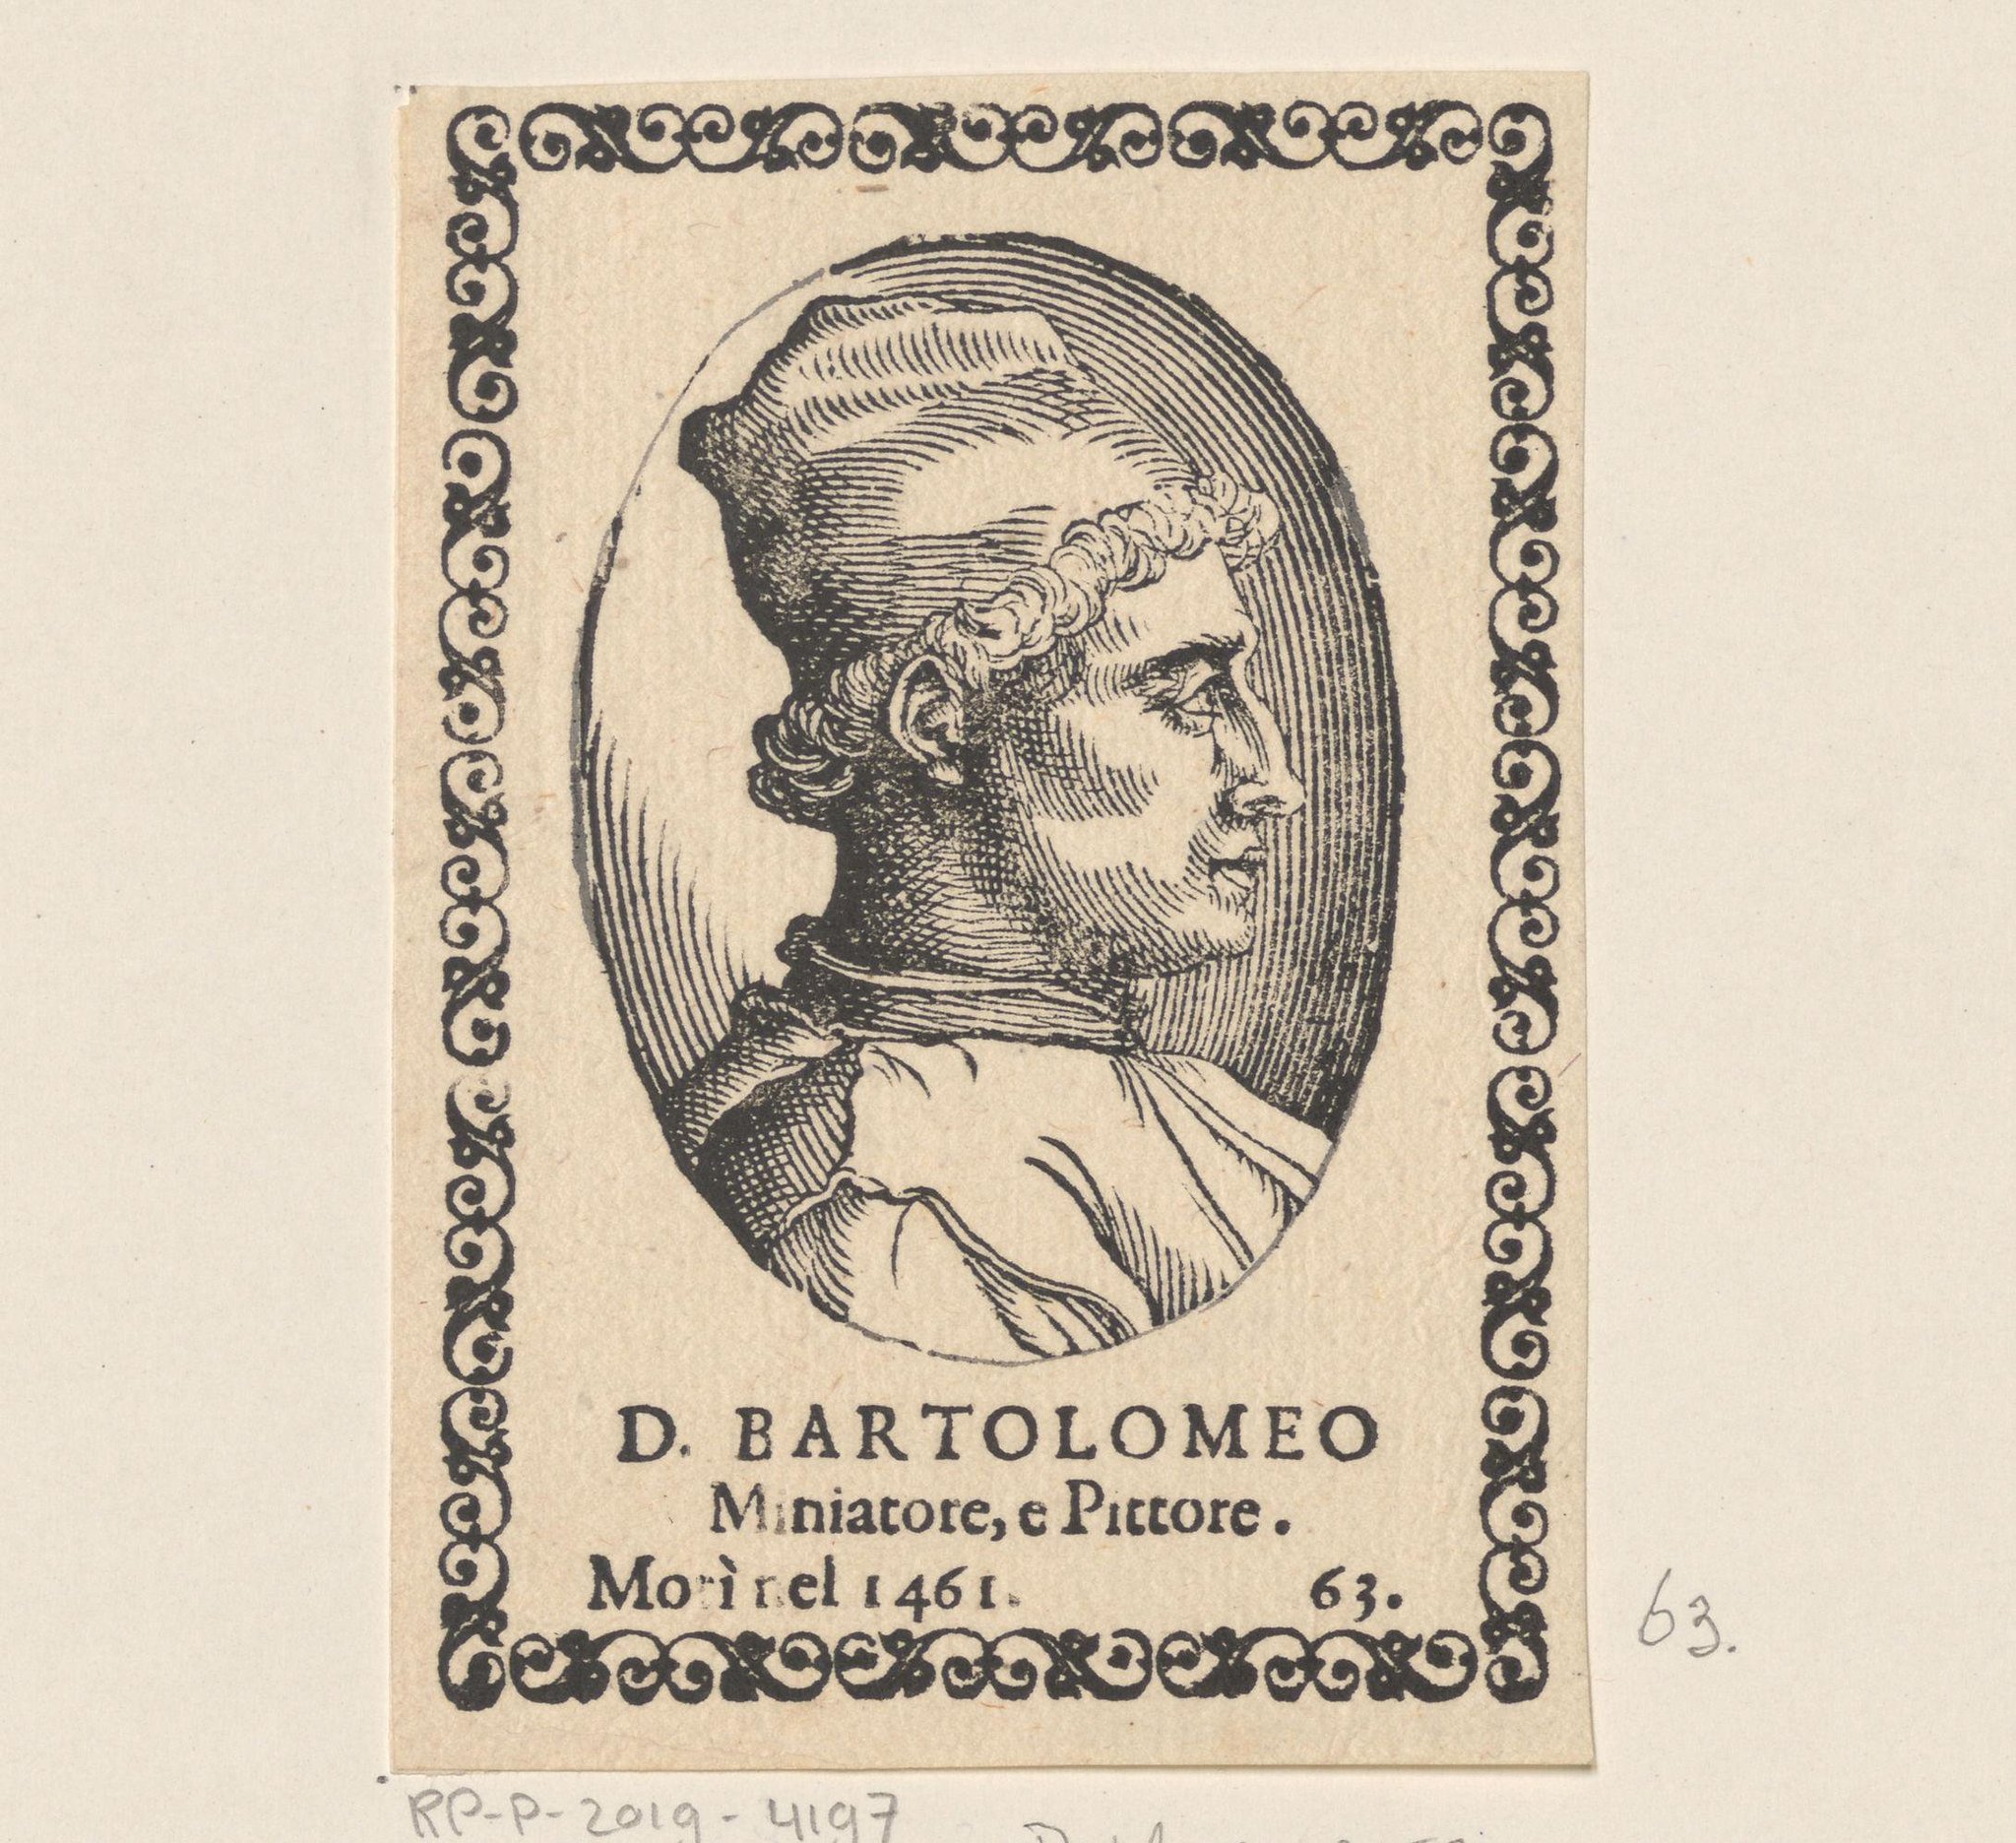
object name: print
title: Portret van Bartolomeo della Gatta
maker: Anonymous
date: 1600-1699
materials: paper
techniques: letterpress printing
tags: bartolomeo della gatta, historical persons, portrait, self-portrait of artist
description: Prent waarschijnlijk afkomstig uit een Italiaanse editie van: Vasari, Giorgio. Vite de' più eccellenti architetti, pittori, et scultori italiani (...).